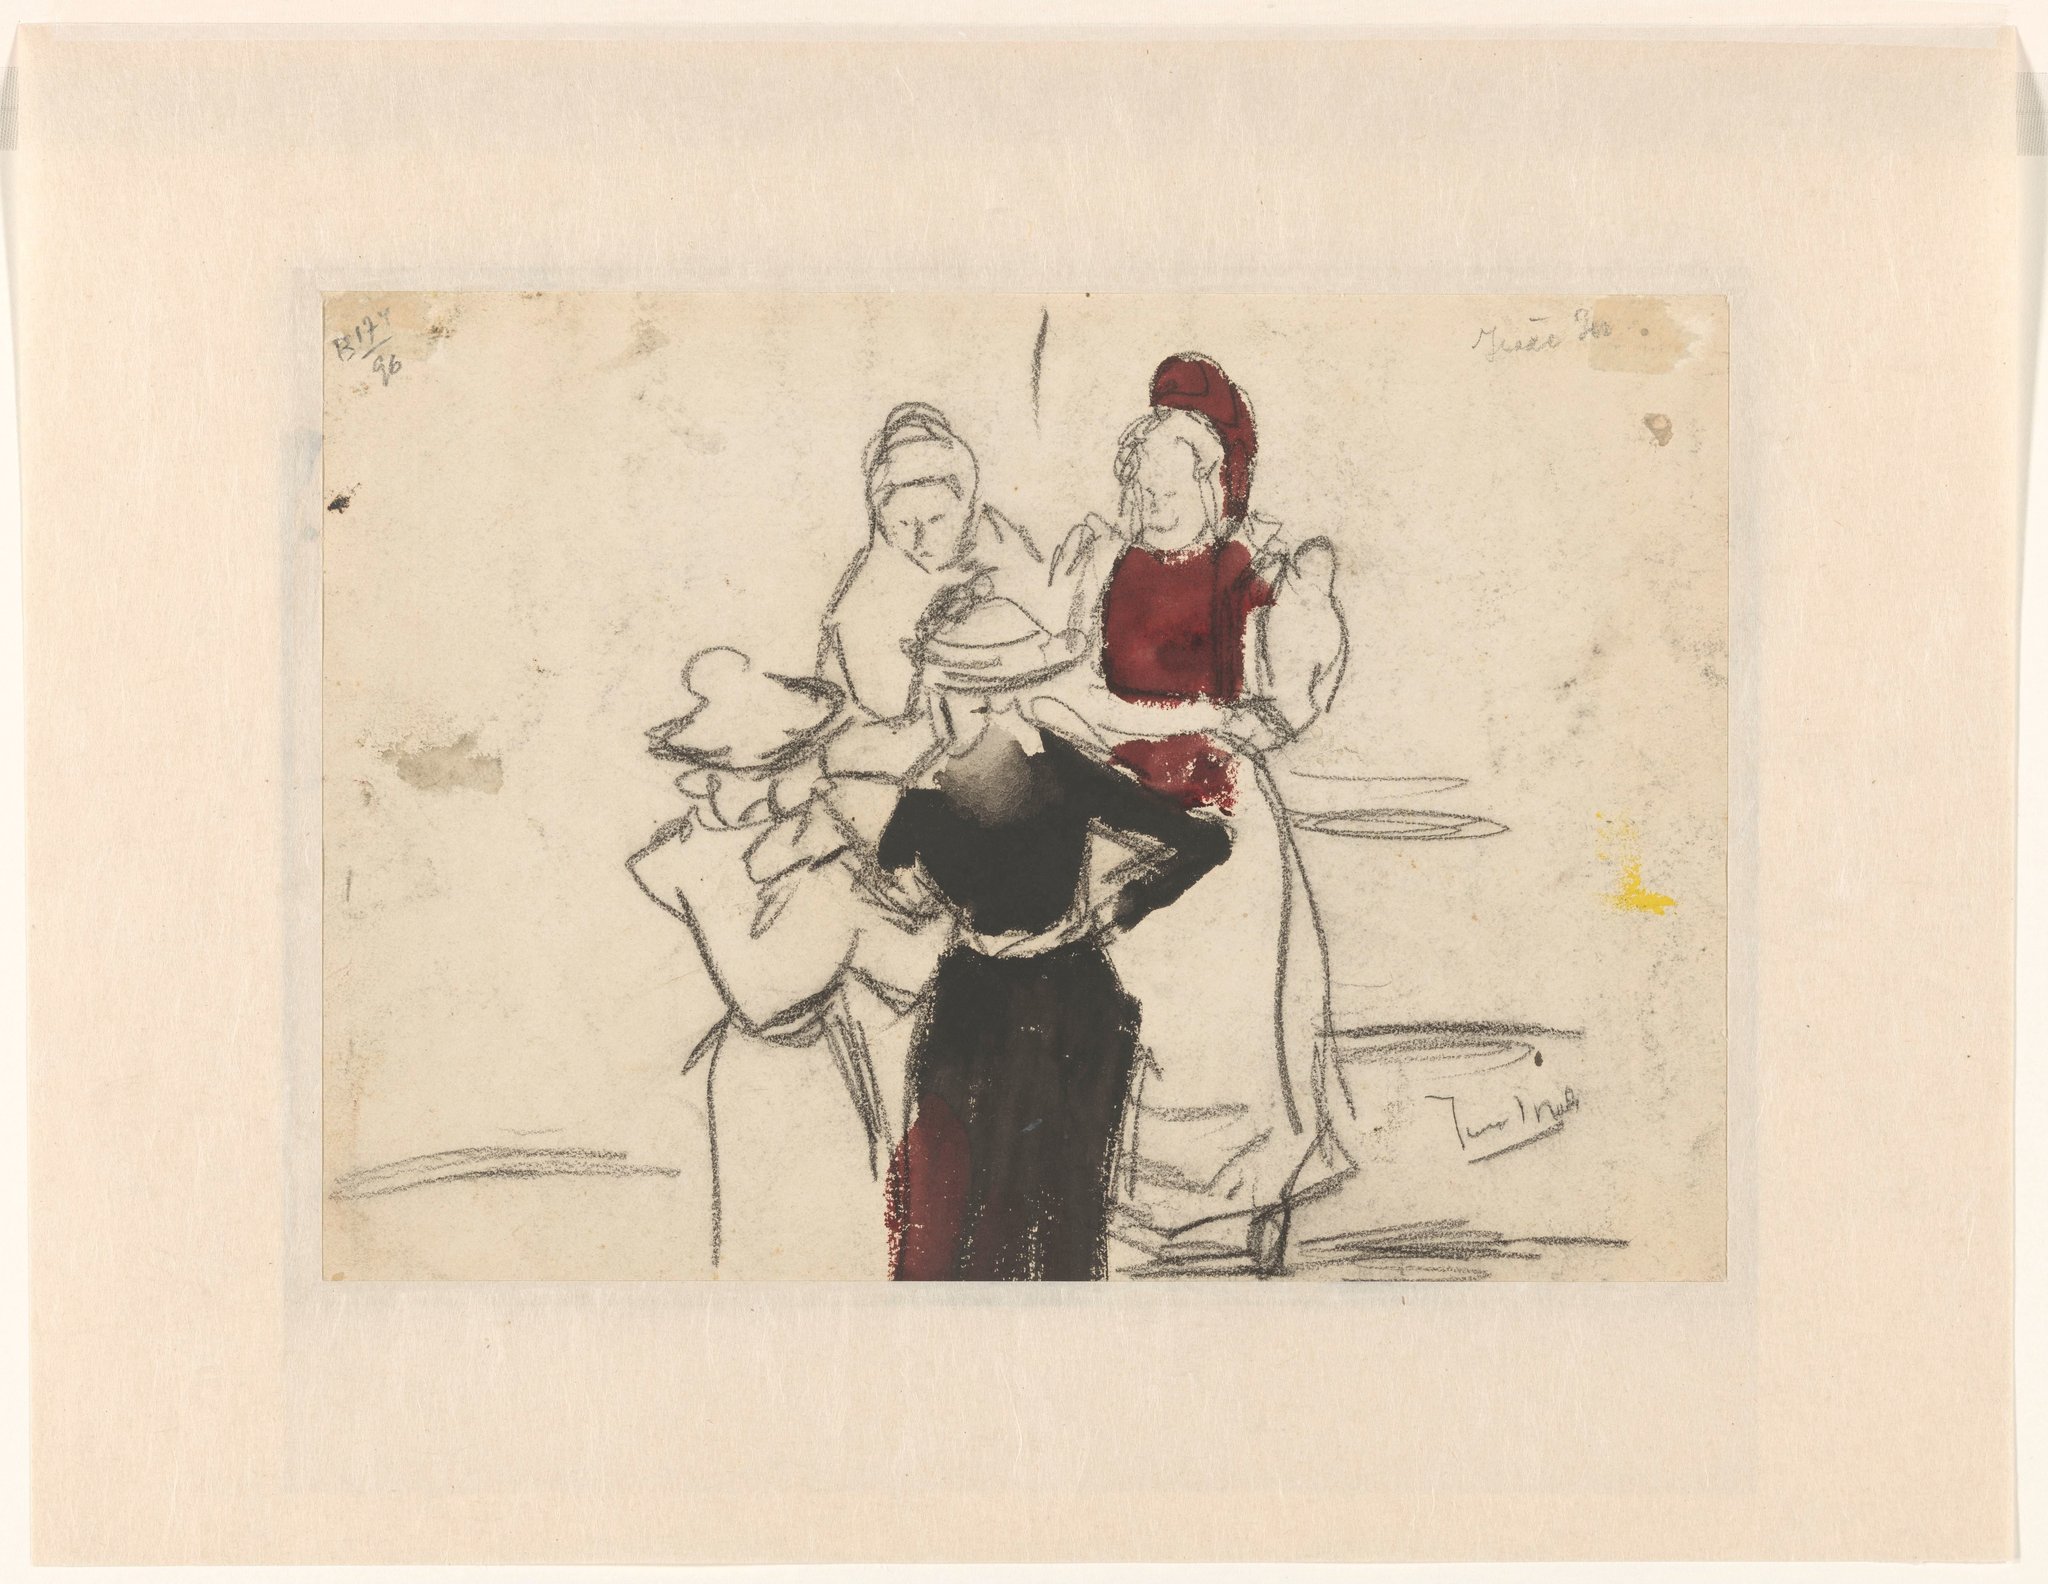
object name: drawing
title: Groepje van vier vrouwen en meisjes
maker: isaac israels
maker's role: draughtsman, painter, print maker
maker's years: 1865-1934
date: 1886-1903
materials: chalk, paper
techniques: brush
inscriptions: signature: ‘Isaac Isr’